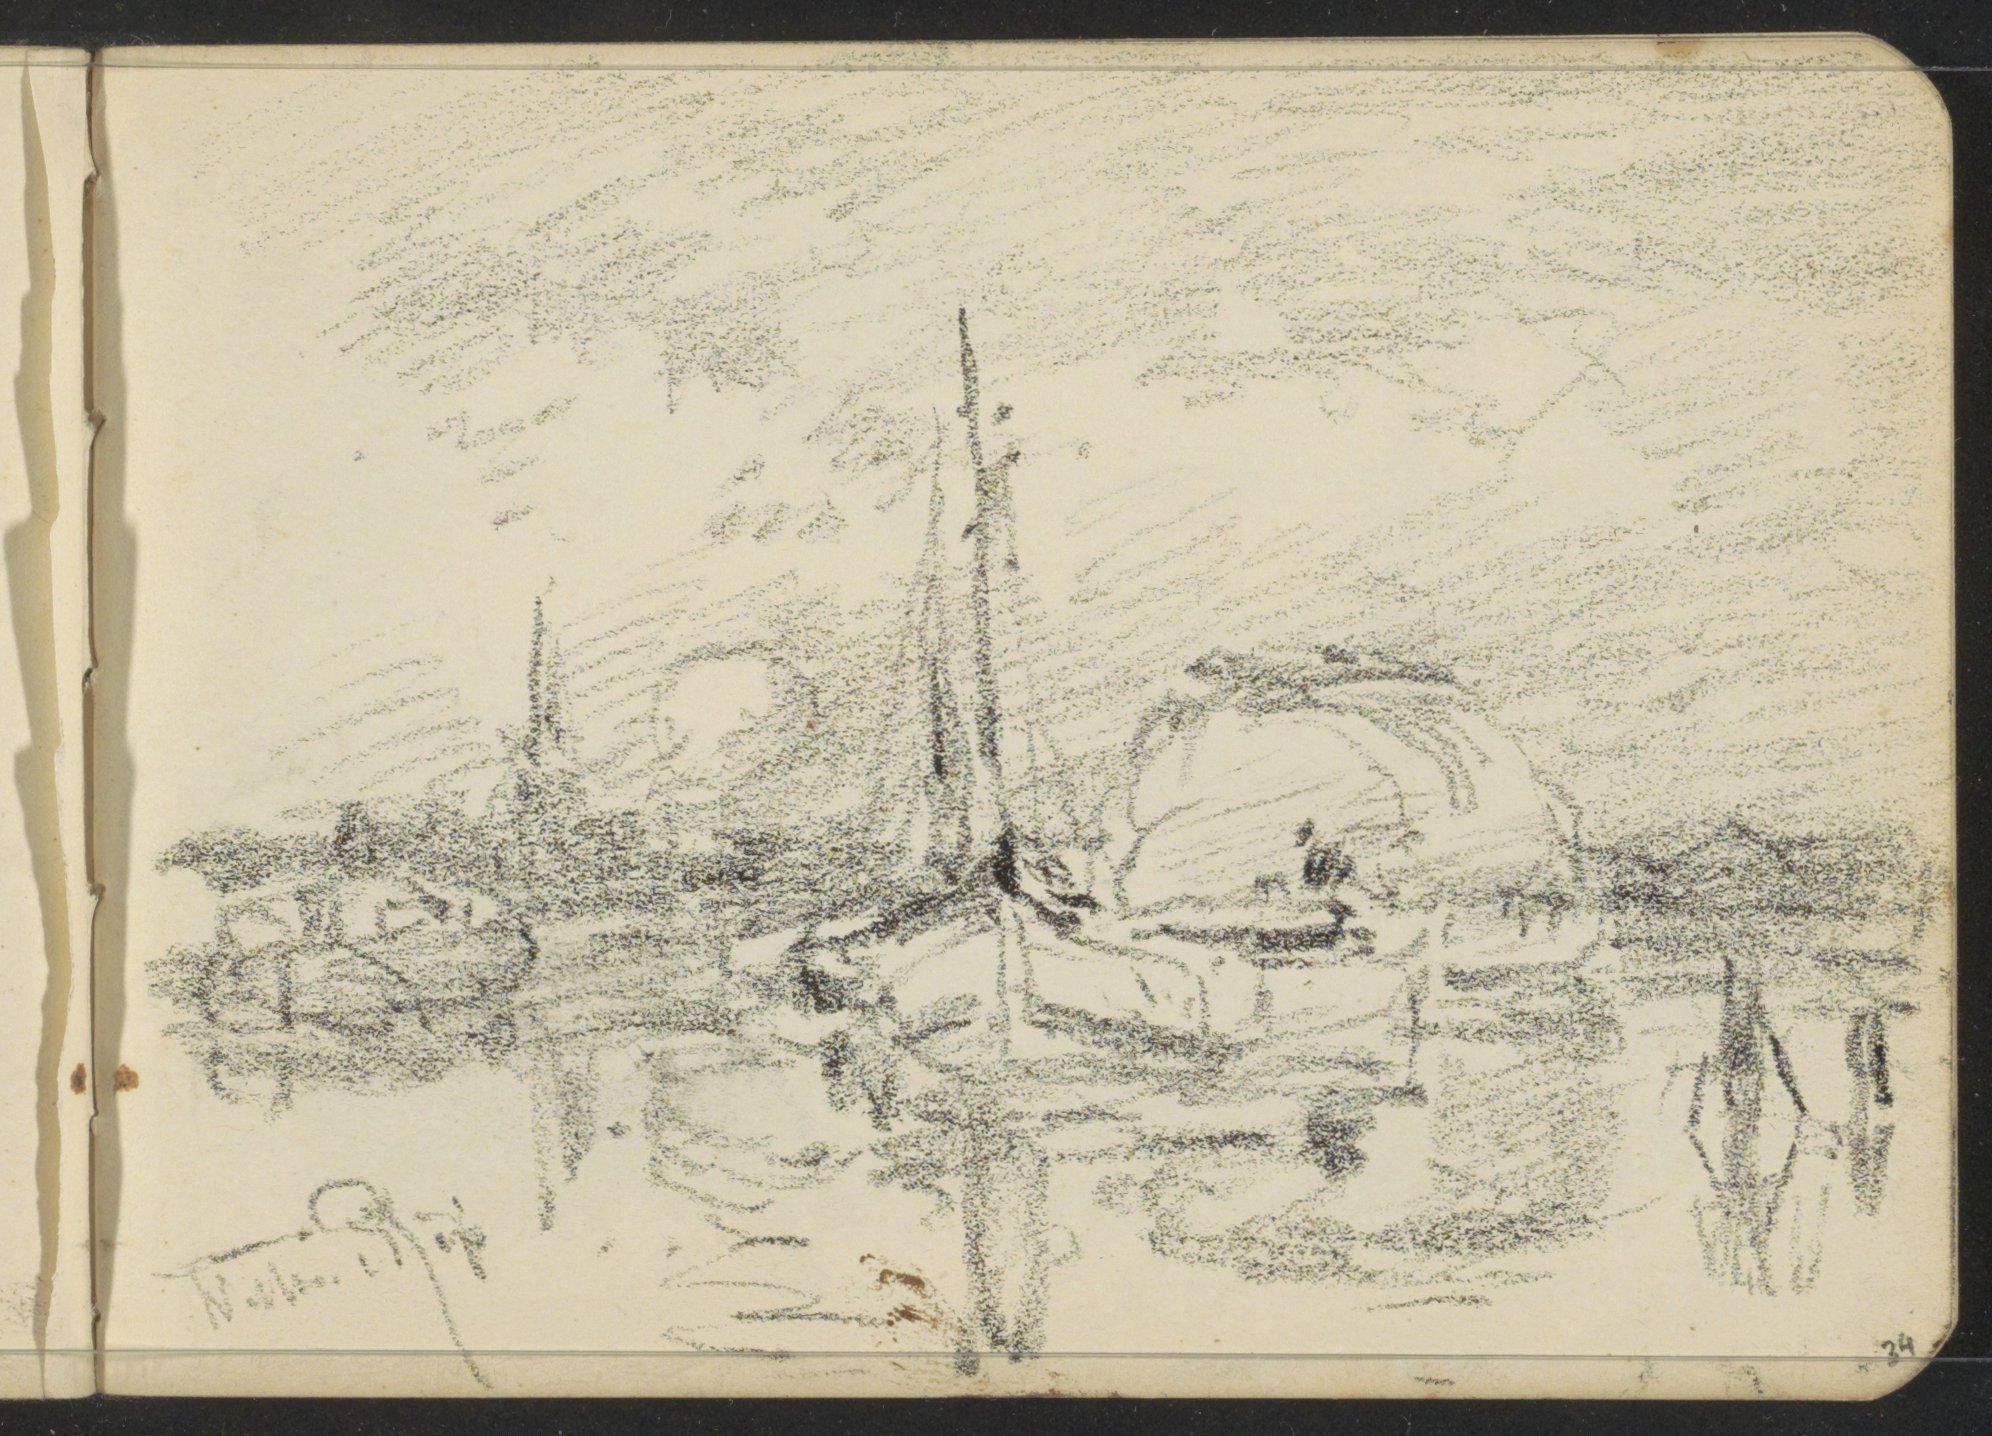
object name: sketchbook leaf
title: Zeilboot op het water voor een dorp of stad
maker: willem cornelis rip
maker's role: draughtsman, painter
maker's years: 1856-1922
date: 1914-1916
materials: chalk, paper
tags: city-view, and landscape with man-made constructions, sailing-ship, sailing-boat, landscapes with waters, waterscapes, seascapes (in the temperate zone)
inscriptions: signature: ‘Willem c Rip’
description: Op de achtergrond zijn de contouren van huizen en een kerktoren te zien. Blad 34 recto uit een schetsboek met 41 bladen.